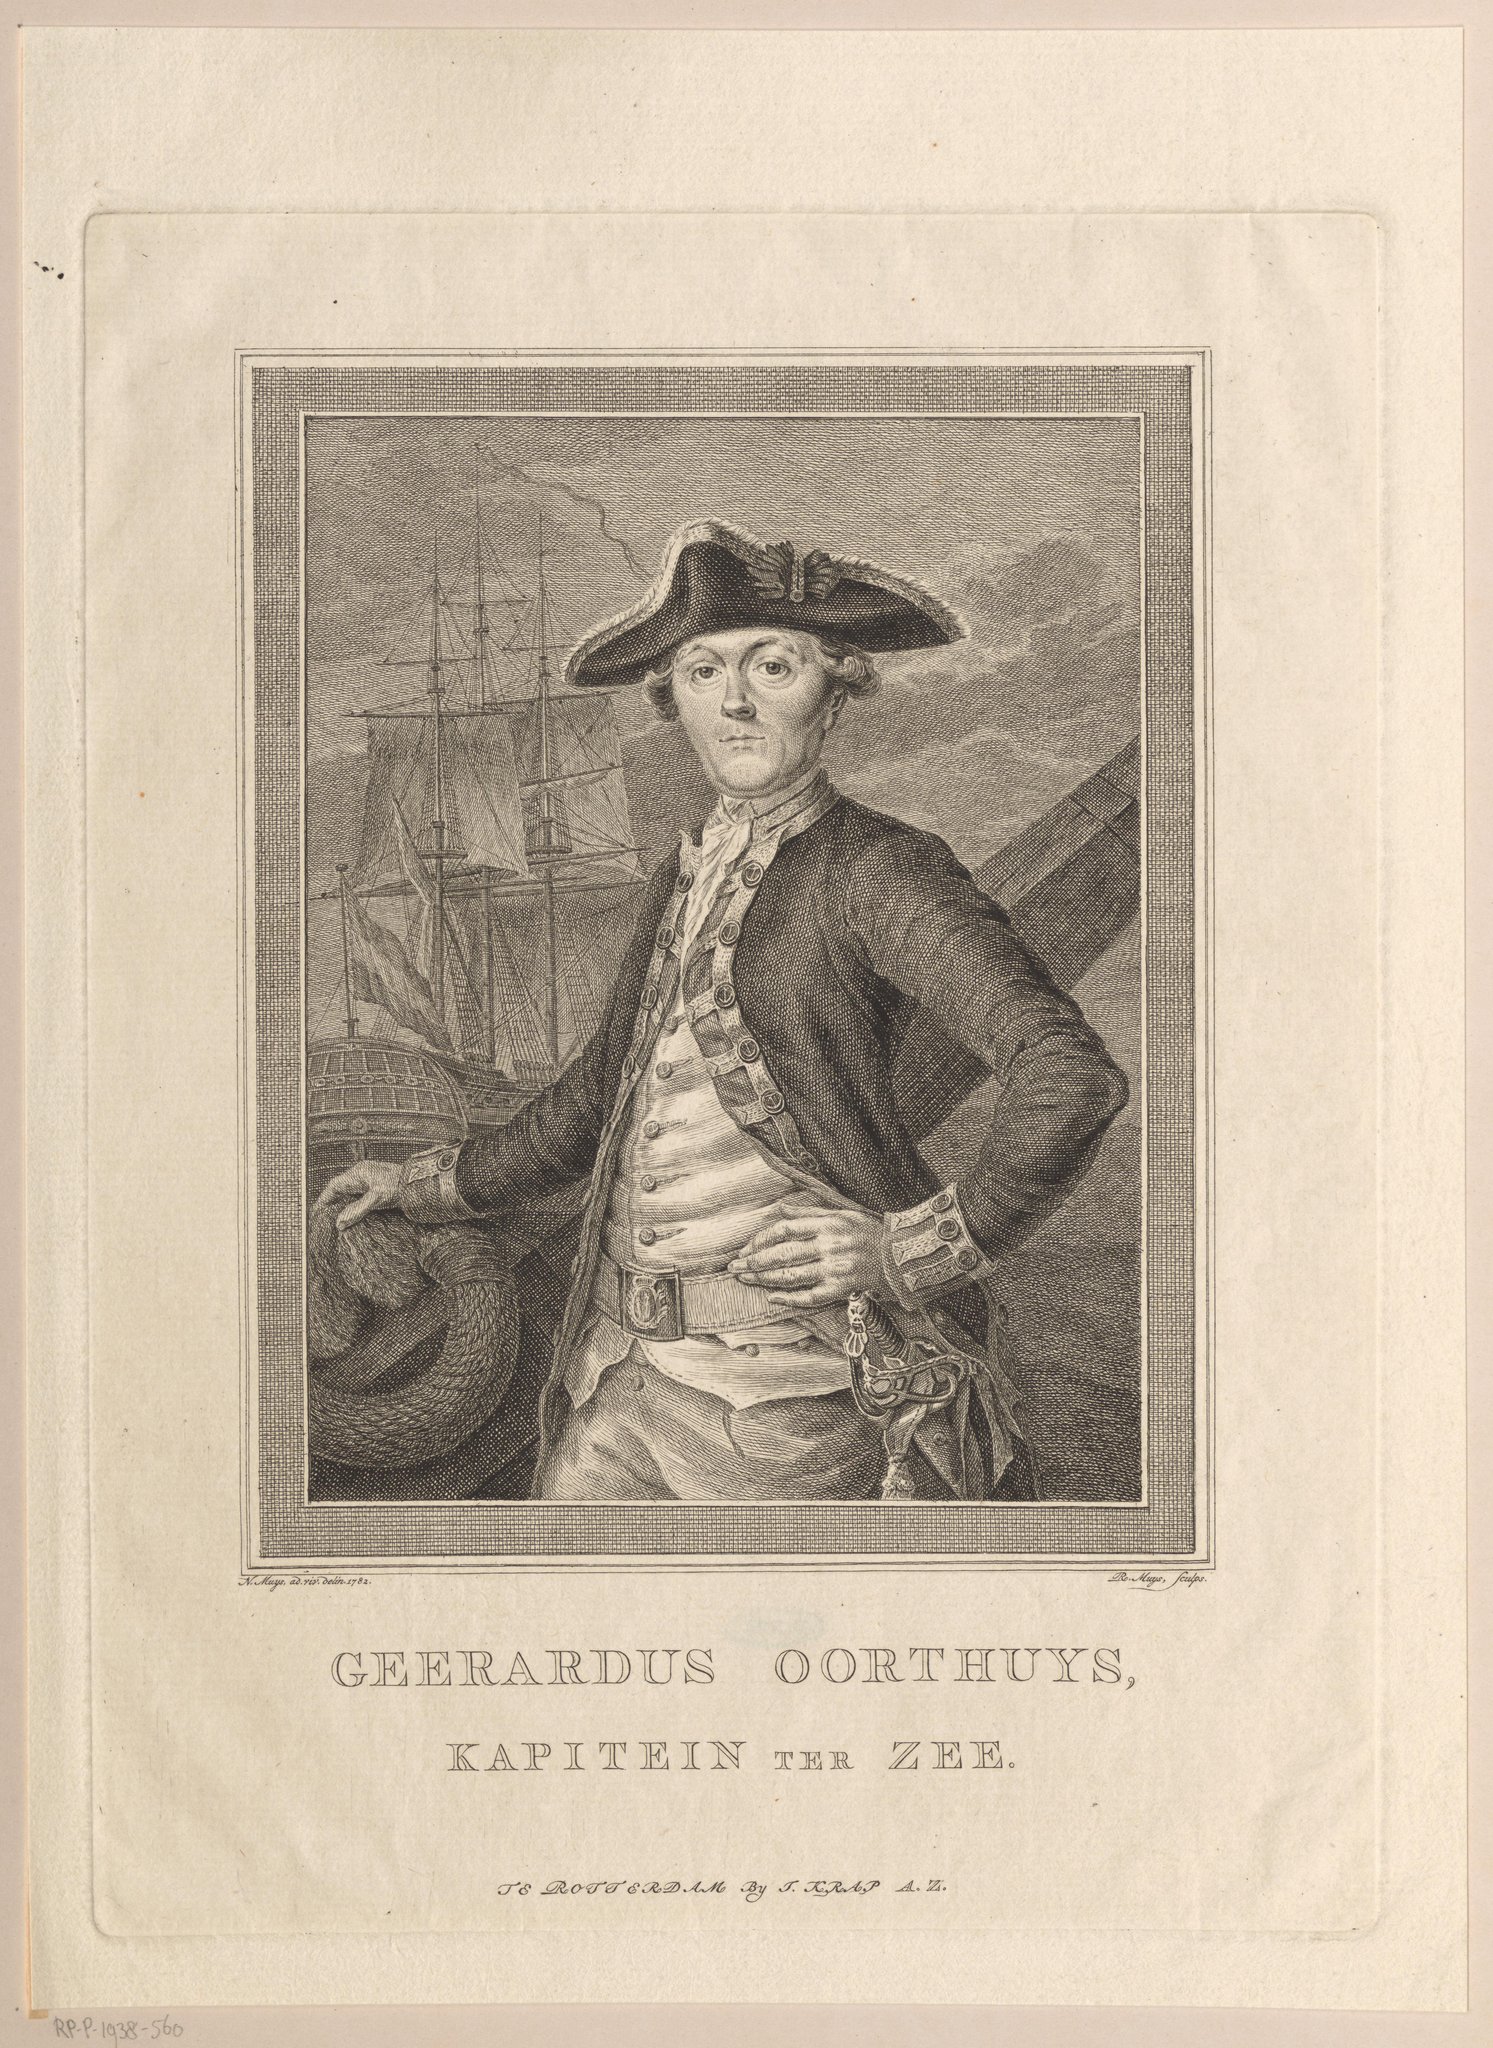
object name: print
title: Portret van Gerardus Oorthuys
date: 1782-1825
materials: paper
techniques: engraving, etching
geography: rotterdam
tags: gerardus oorthuys, historical persons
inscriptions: collector's mark: Lugt 2228